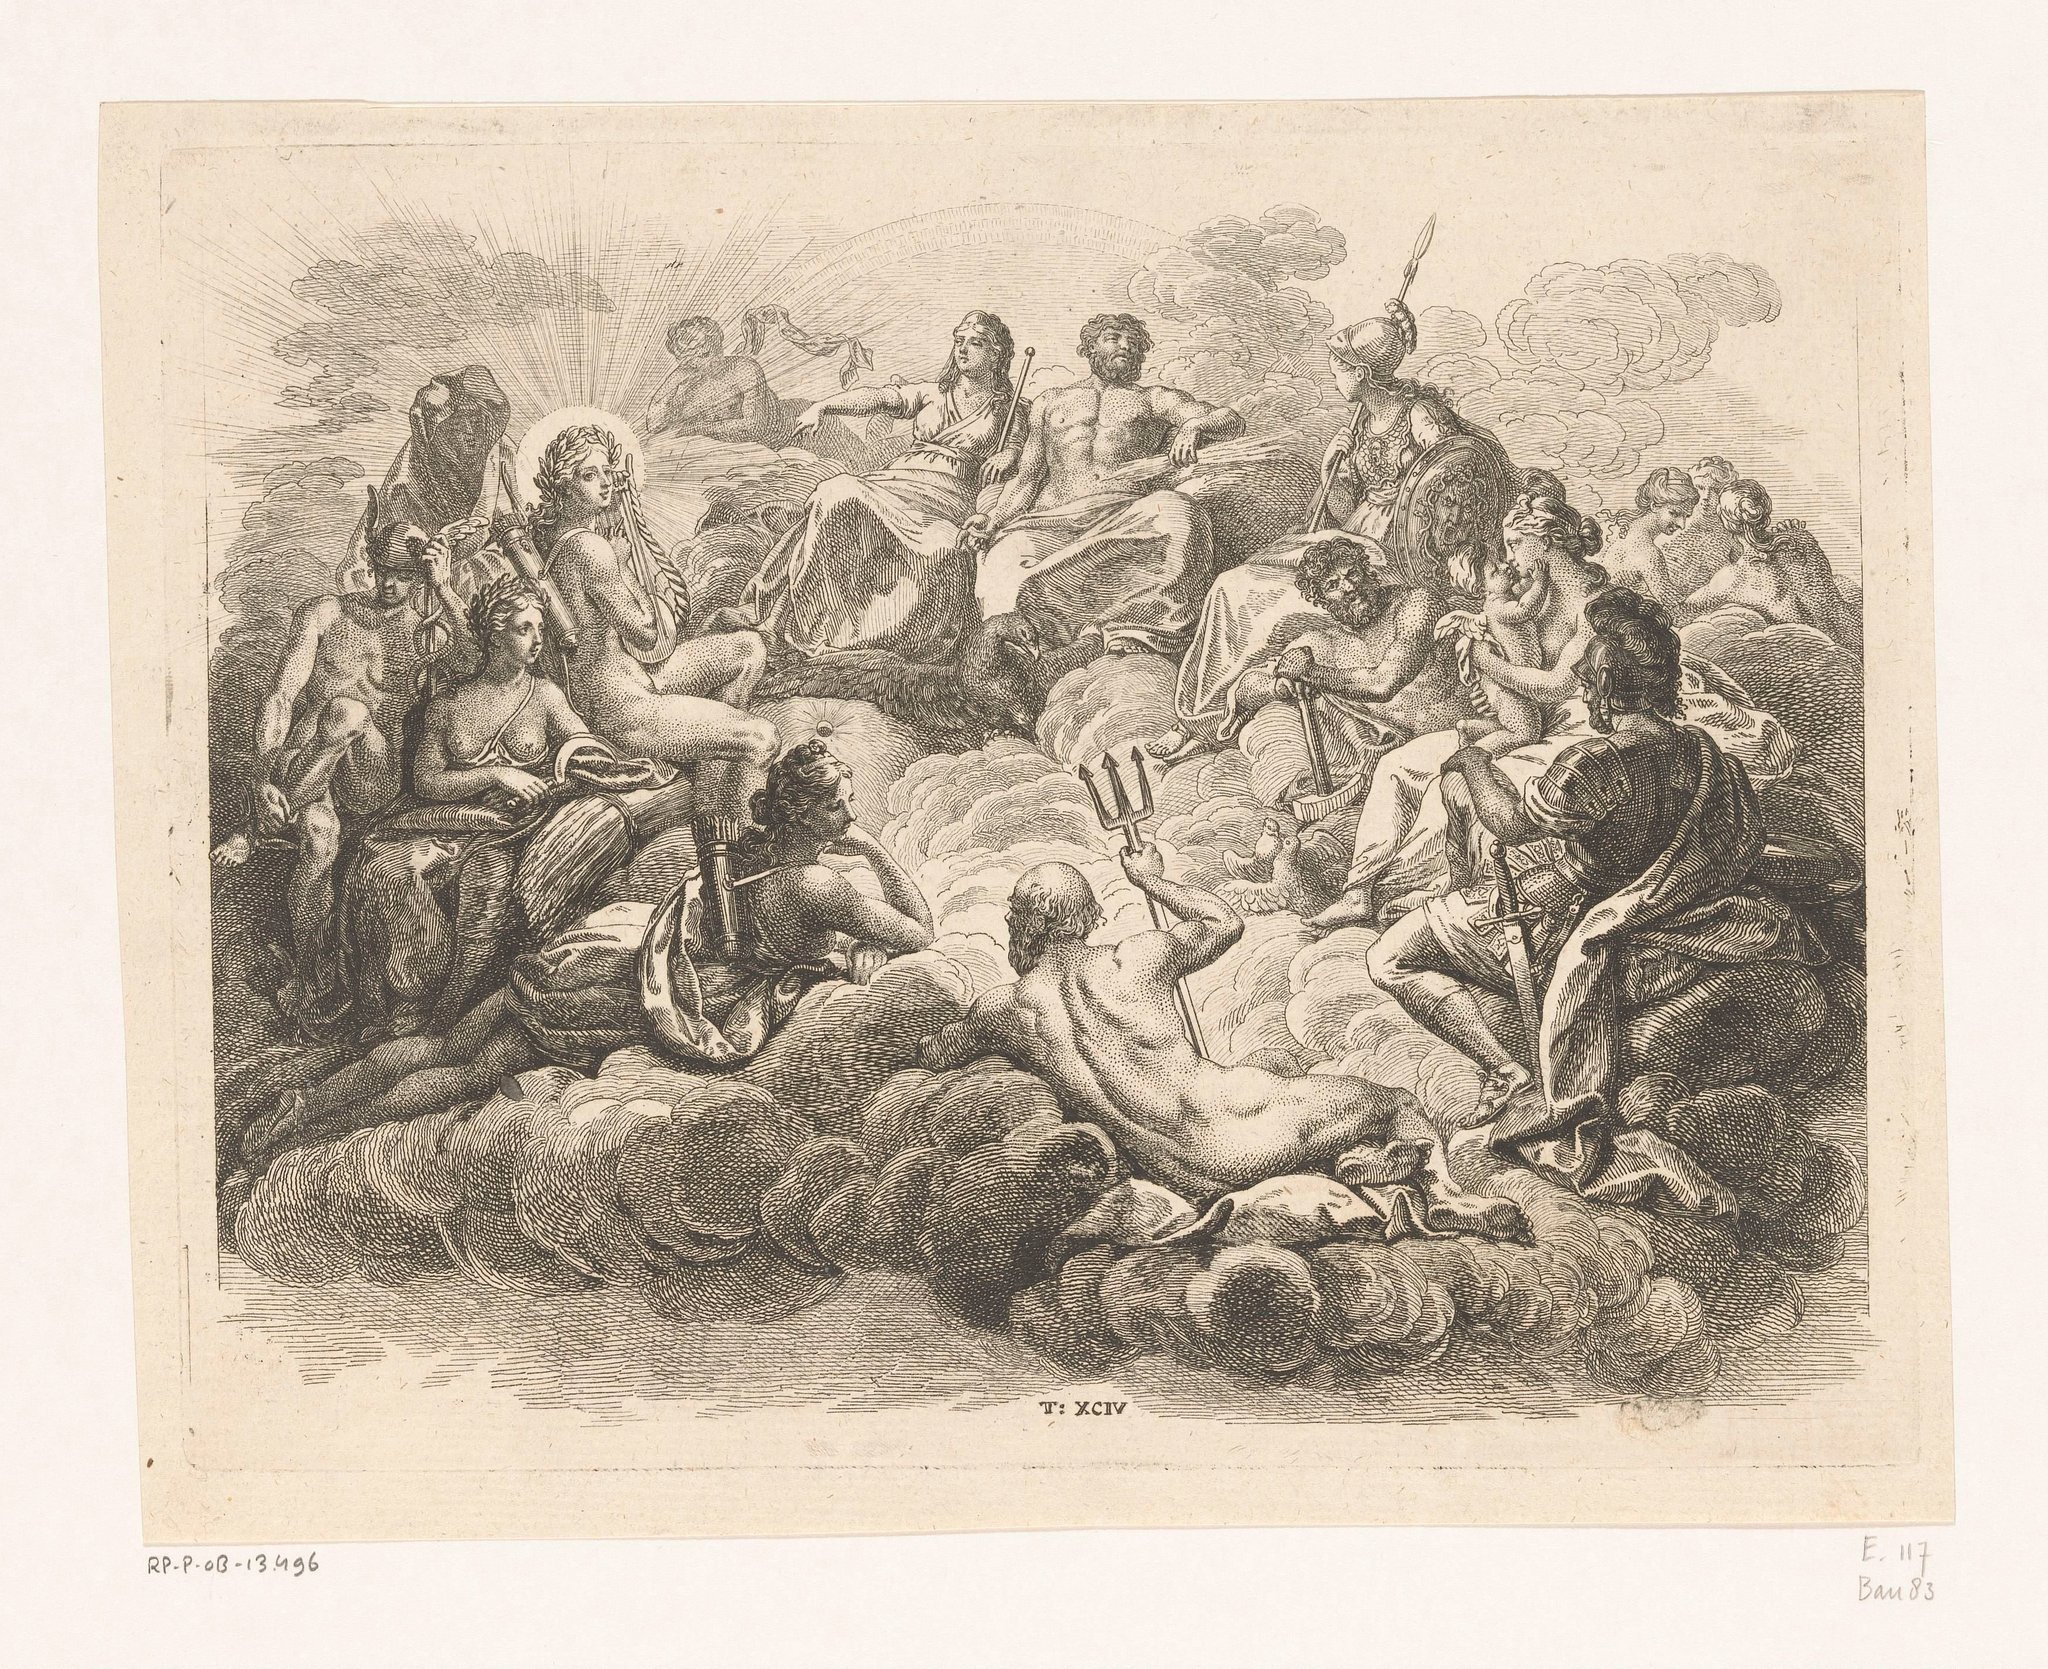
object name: print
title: Verzameling der goden op de Olympus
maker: daniel nikolaus chodowiecki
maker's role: draughtsman, print maker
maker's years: 1726-1801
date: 1774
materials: paper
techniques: etching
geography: berlin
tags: johann bernhard basedow, the olympian gods together: jupiter, juno, neptune, ceres, apollo, diana, mars, venus, mercury, minerva, vulcan, vesta (or bacchus)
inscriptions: collector's mark: Lugt 2228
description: De naam van de kunstenaar is van het papier weggekrast. De prent maakt onderdeel uit van een serie van 96 prenten die verschenen ter illustratie van het 'Elementarwerk' van de Duitse pedagoog Johann Bernhard Basedow. De prenten werden door verschillende kunstenaars vervaardigd naar tekeningen van Daniel Chodowiecki. In 1774 verscheen het verzamelde prentwerk onder de titel: Kupfersammlung zu J.B. Basedows Elementarwerk für die Jugend und ihre Freunde.